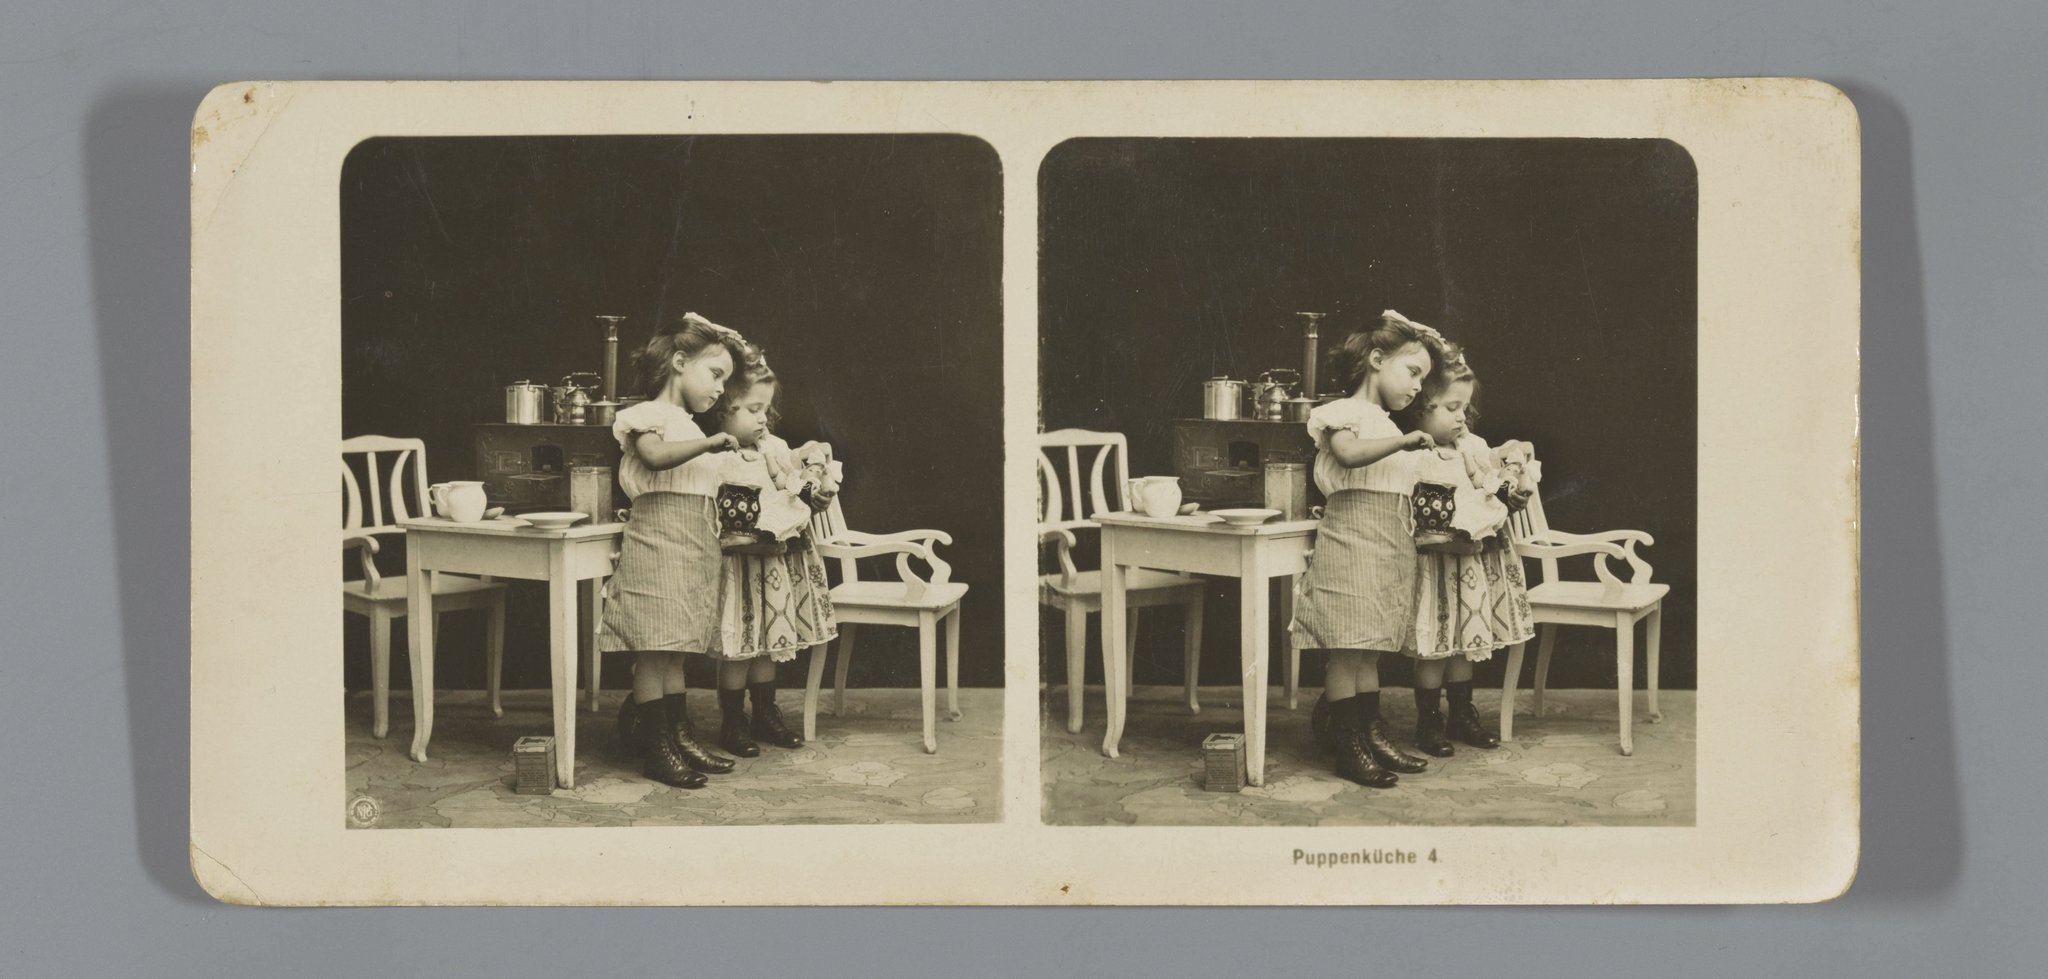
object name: stereograph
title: Puppenküche 4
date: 1900-1920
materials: cardboard, photographic support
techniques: gelatin silver print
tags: children's games and plays, (playing with) toys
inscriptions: monogram: ‘NPG’